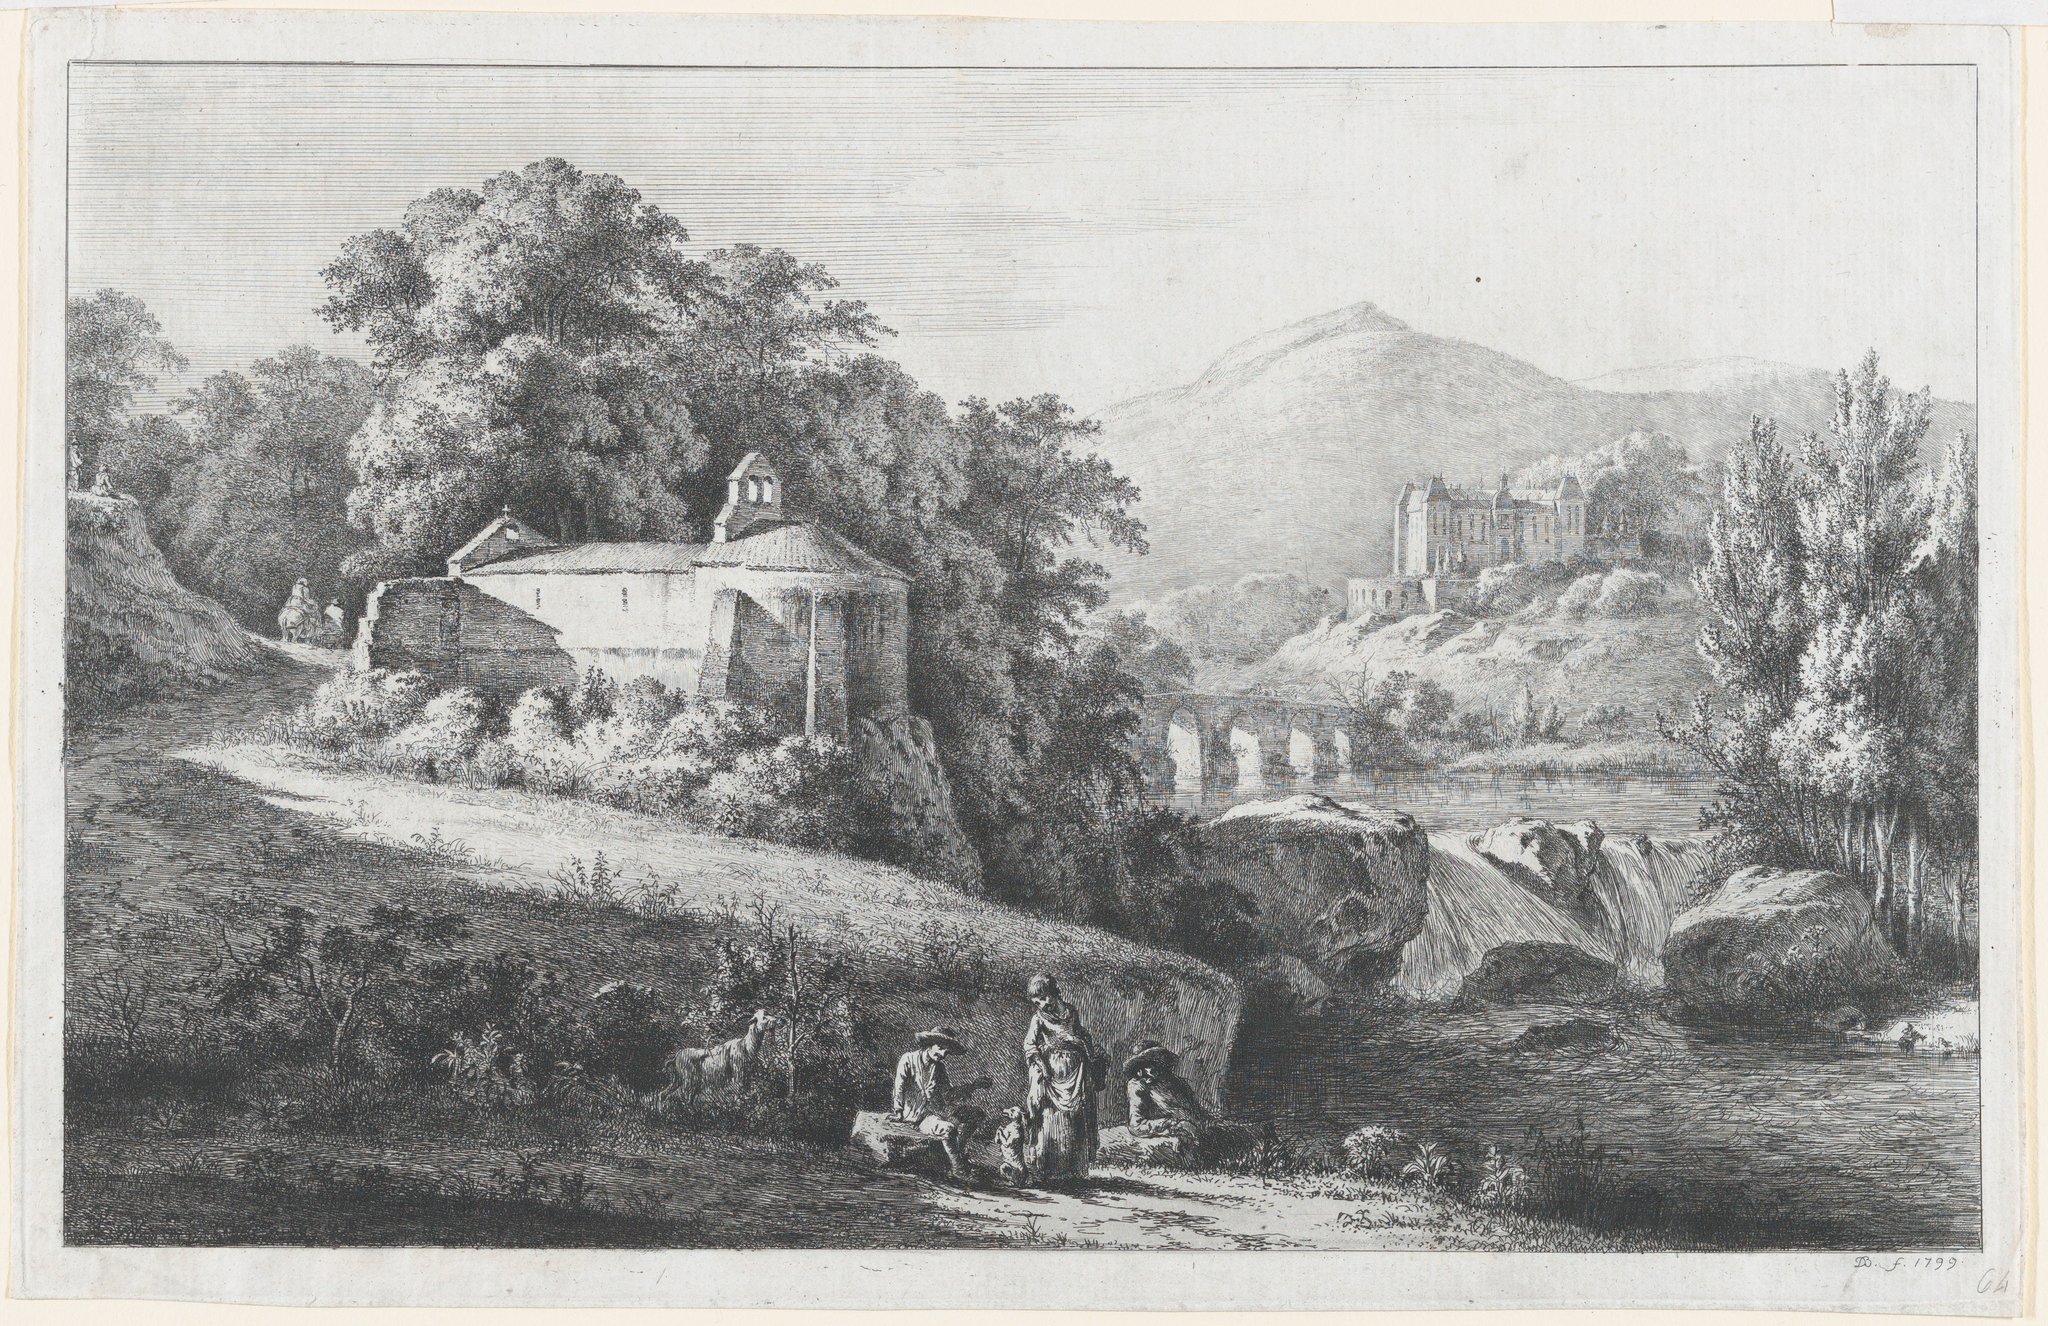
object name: print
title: The Old Chapel at Châtillon-d'Azergues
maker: jean jacques de boissieu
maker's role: artist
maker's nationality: french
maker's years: 1736-1810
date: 1799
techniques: drypoint, etching, roulette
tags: landscapes,chapels